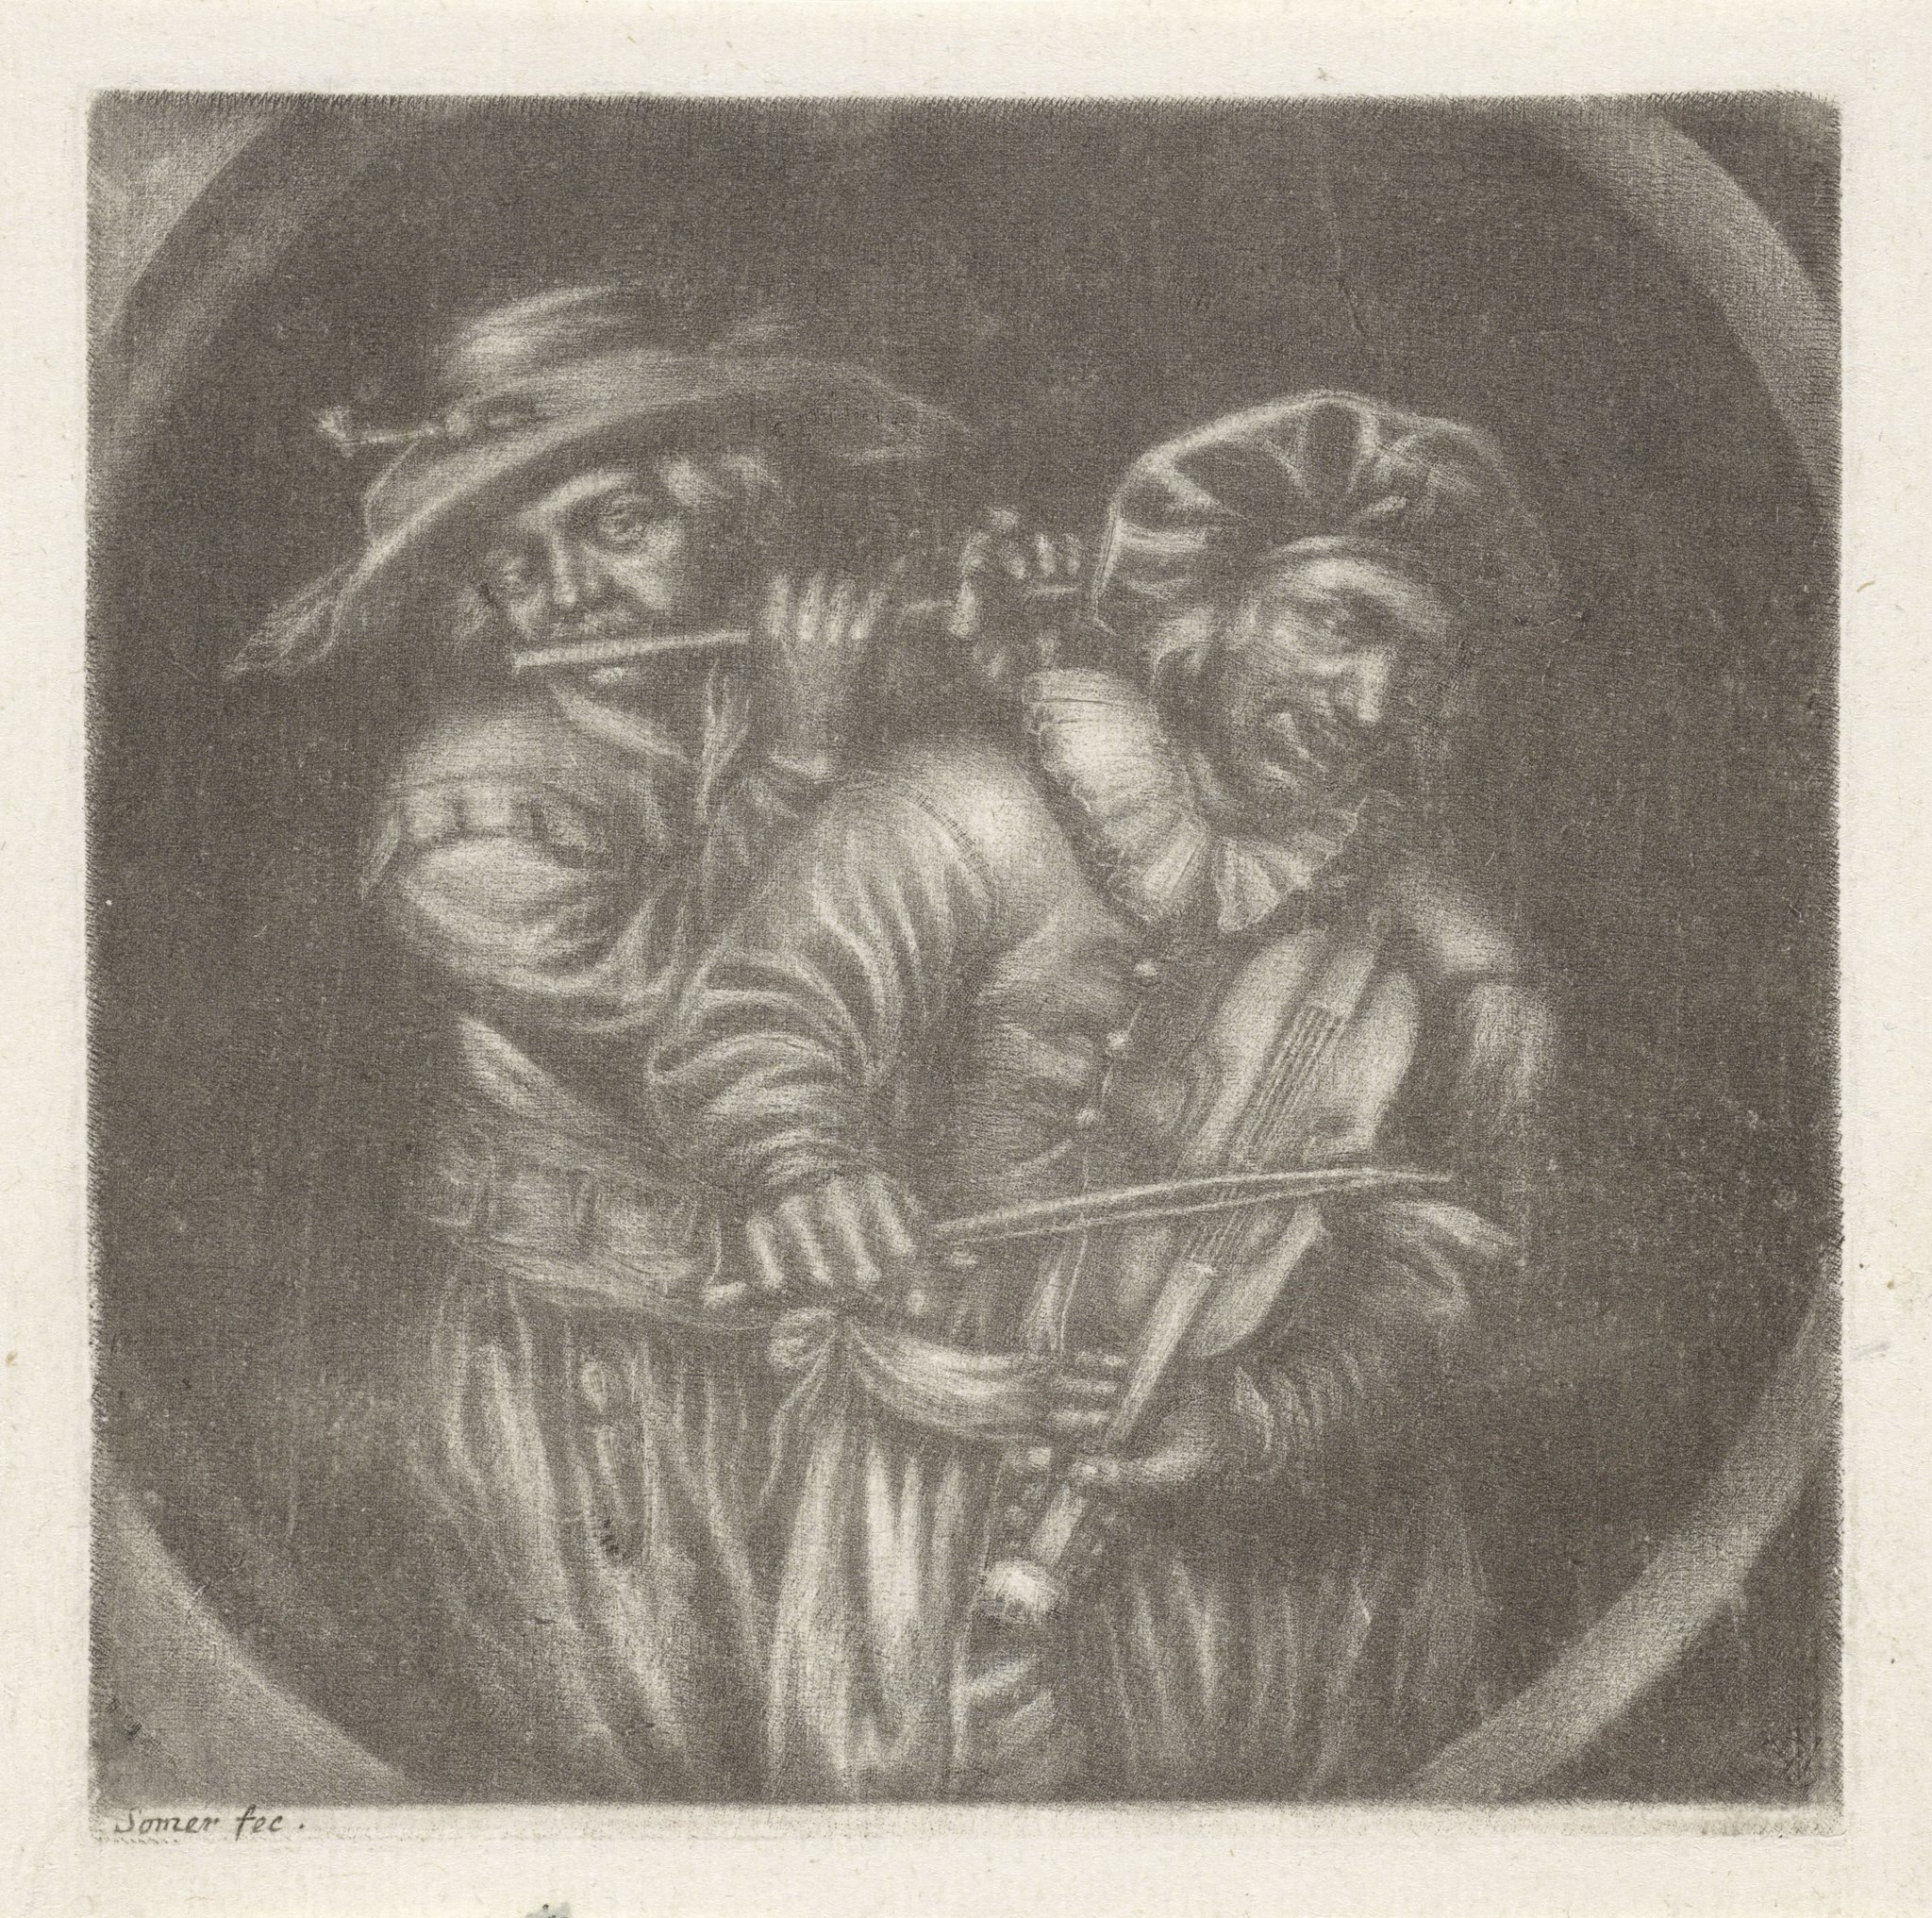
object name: print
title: Muzikanten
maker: jan van somer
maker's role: draughtsman, print maker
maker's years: 1645-1699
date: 1655-1700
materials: paper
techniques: mezzotint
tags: one person playing string instrument (bowed), transverse flute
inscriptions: collector's mark: Lugt 2228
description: Een vioolspeler en een fluitist maken samen muziek.